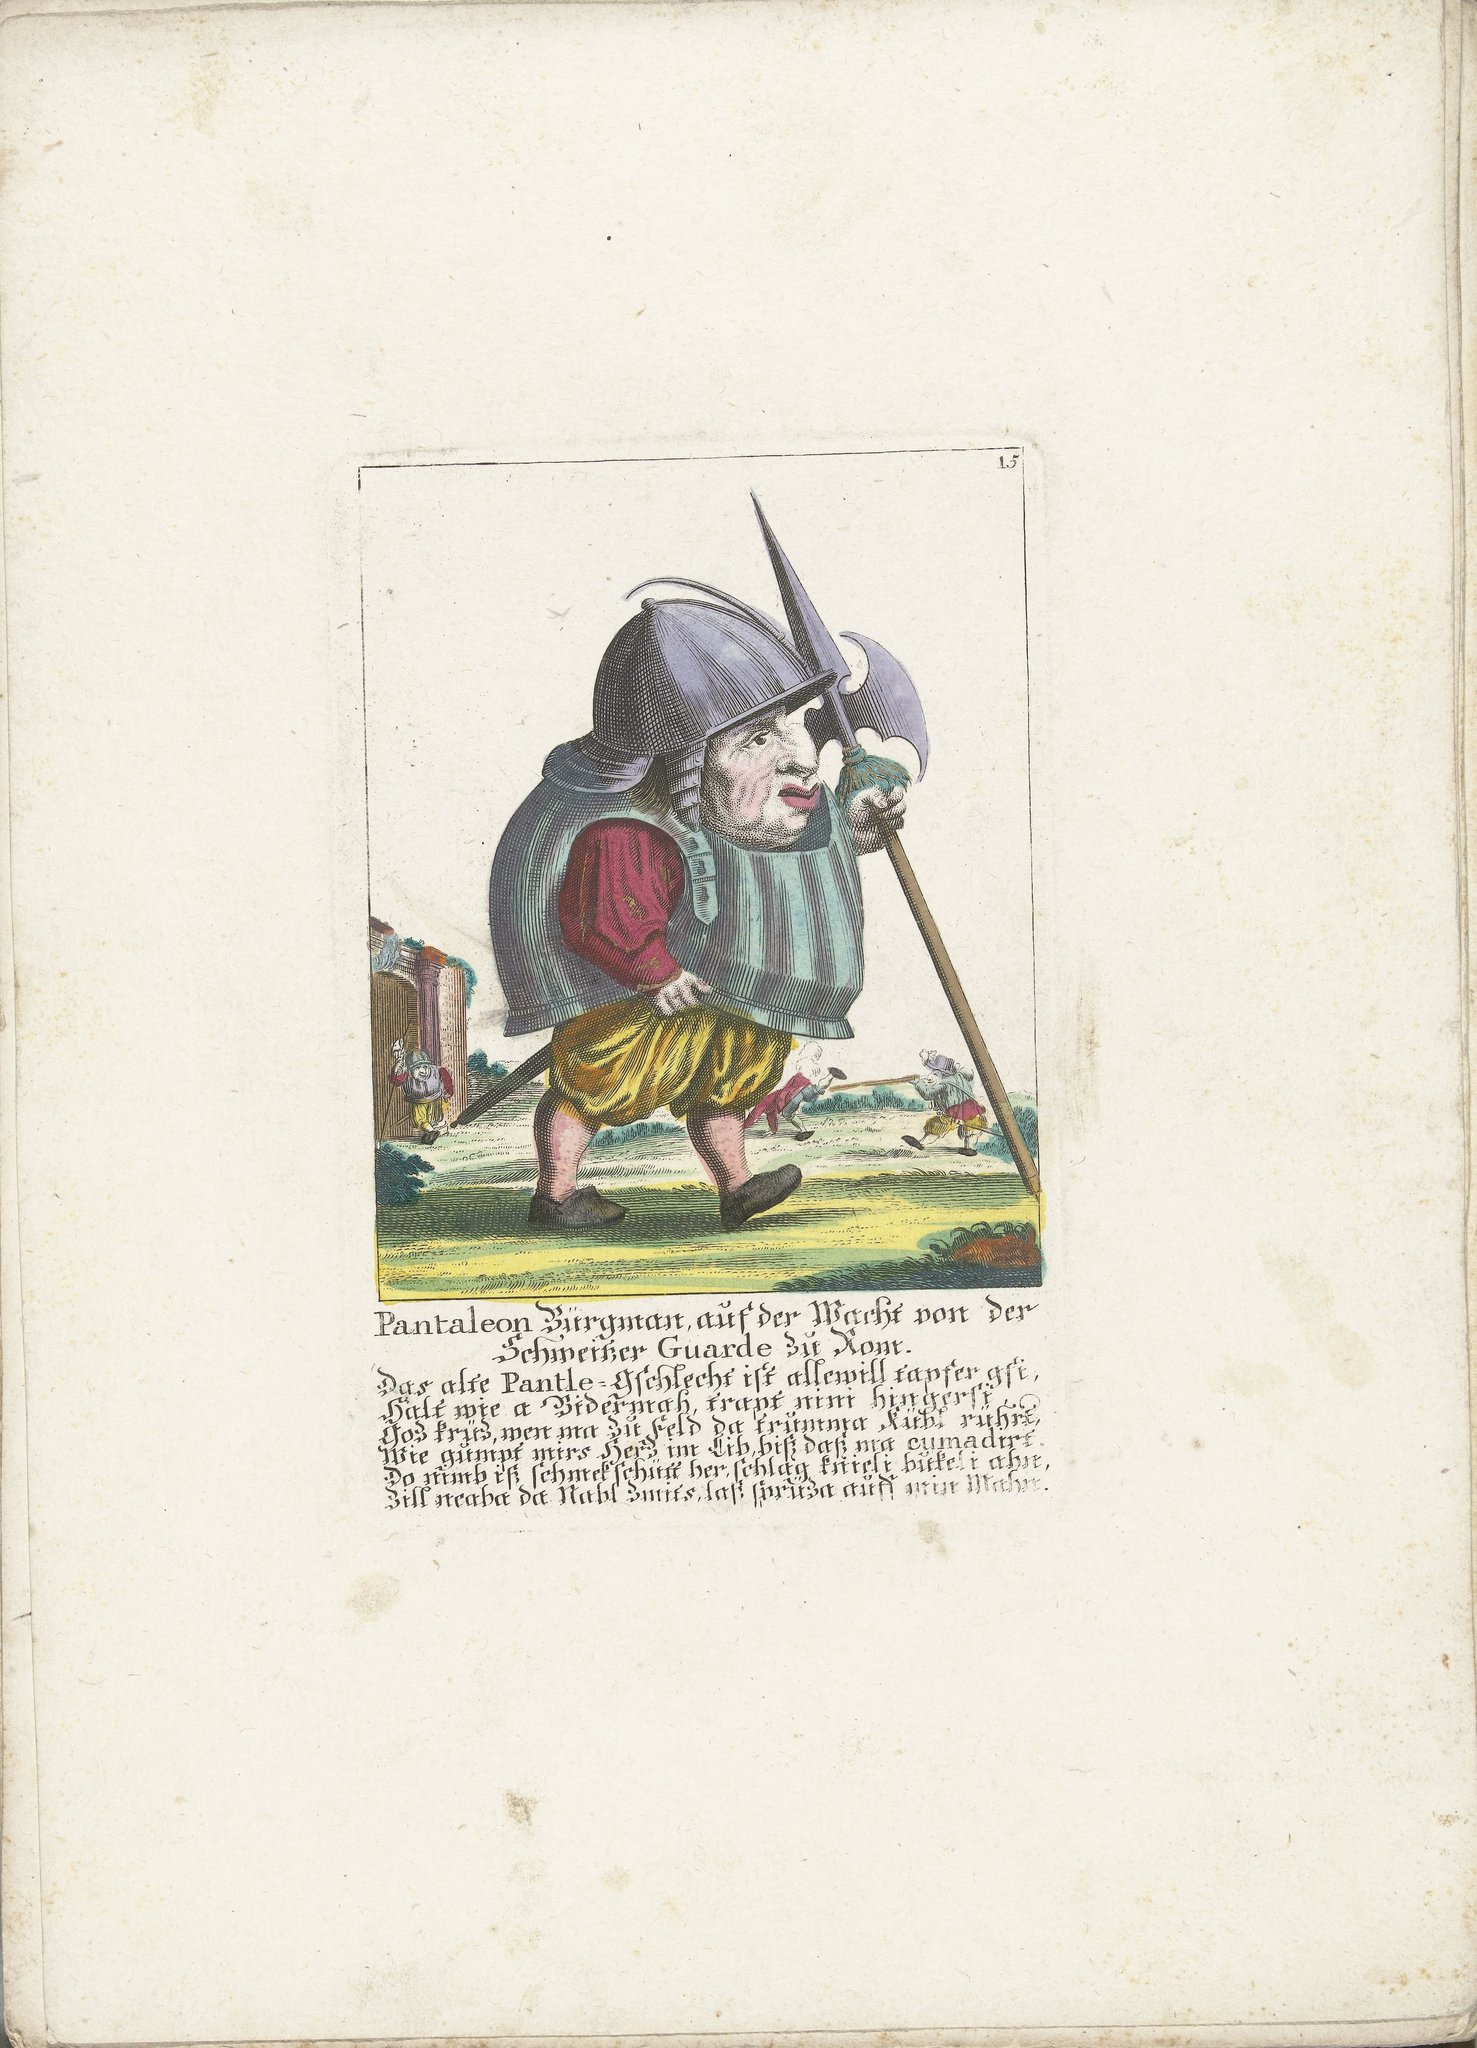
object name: caricature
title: Pantaleon Bürgman, auf der Wacht von der Schweitzer Guarde zu Rom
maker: martin engelbrecht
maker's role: print maker, publisher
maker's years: 1684-1756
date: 1705-1715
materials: paper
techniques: engraving, etching, hand coloring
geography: augsburg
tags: caricatures (human types), little people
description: De kleine mens Pantaleon Bürgman van de Zwitserse Garde te Rome op wacht. In het onderschrift onder de titel een zesregelig vers in het Duits. Genummerd rechtsboven: 15. Onderdeel van een losbladige uitgave uit ca. 1710 van een serie karikaturen van kleine mensen, bekend als Het Dwergentooneel.